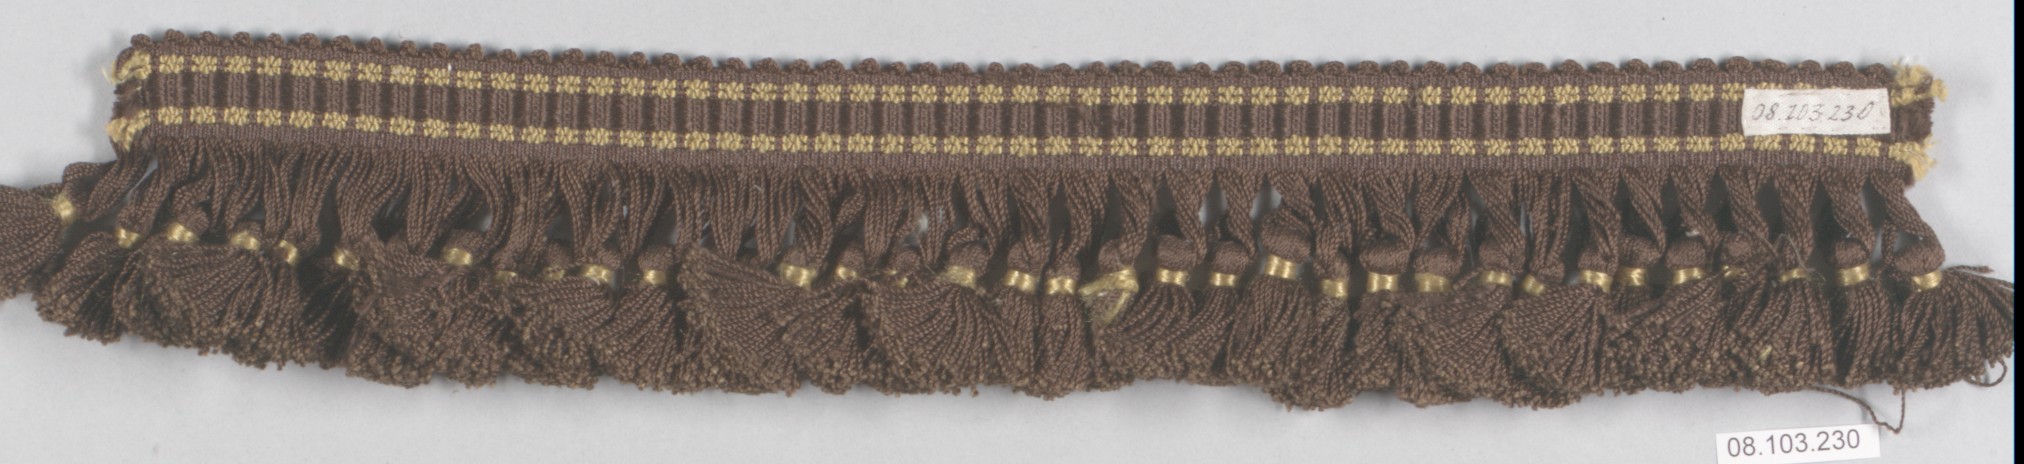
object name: fringe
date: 1801-1900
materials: silk